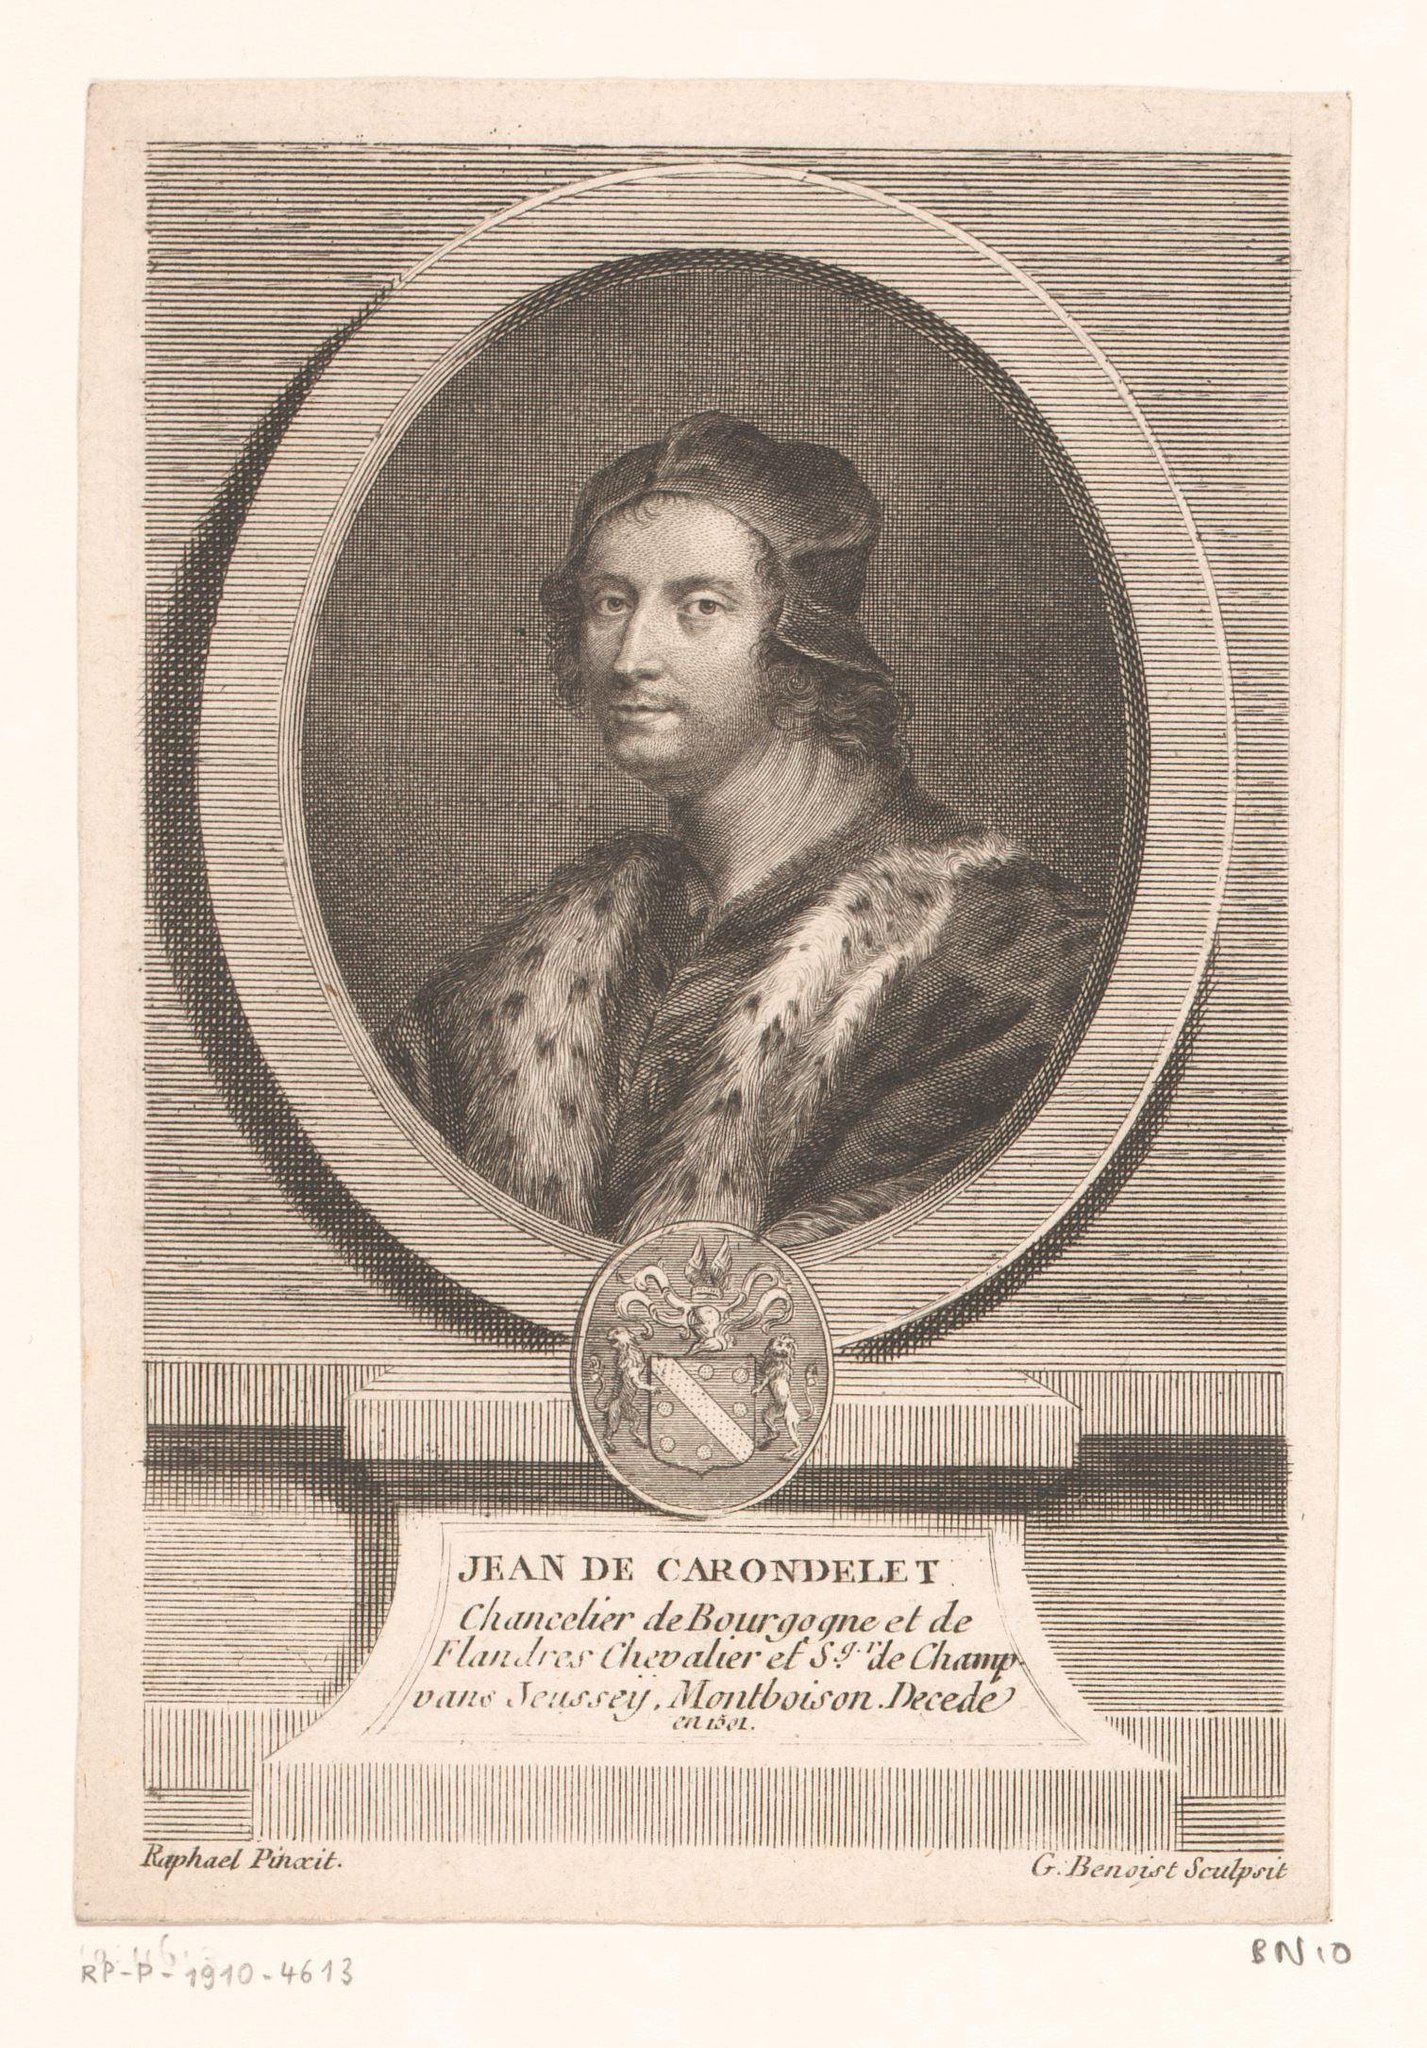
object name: print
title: Portret van Jean Carondelet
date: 1735-1800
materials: paper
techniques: engraving, etching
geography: france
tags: mechelen, ornament ~ medallion, historical persons, armorial bearing, heraldry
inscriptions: collector's mark: Lugt 2228